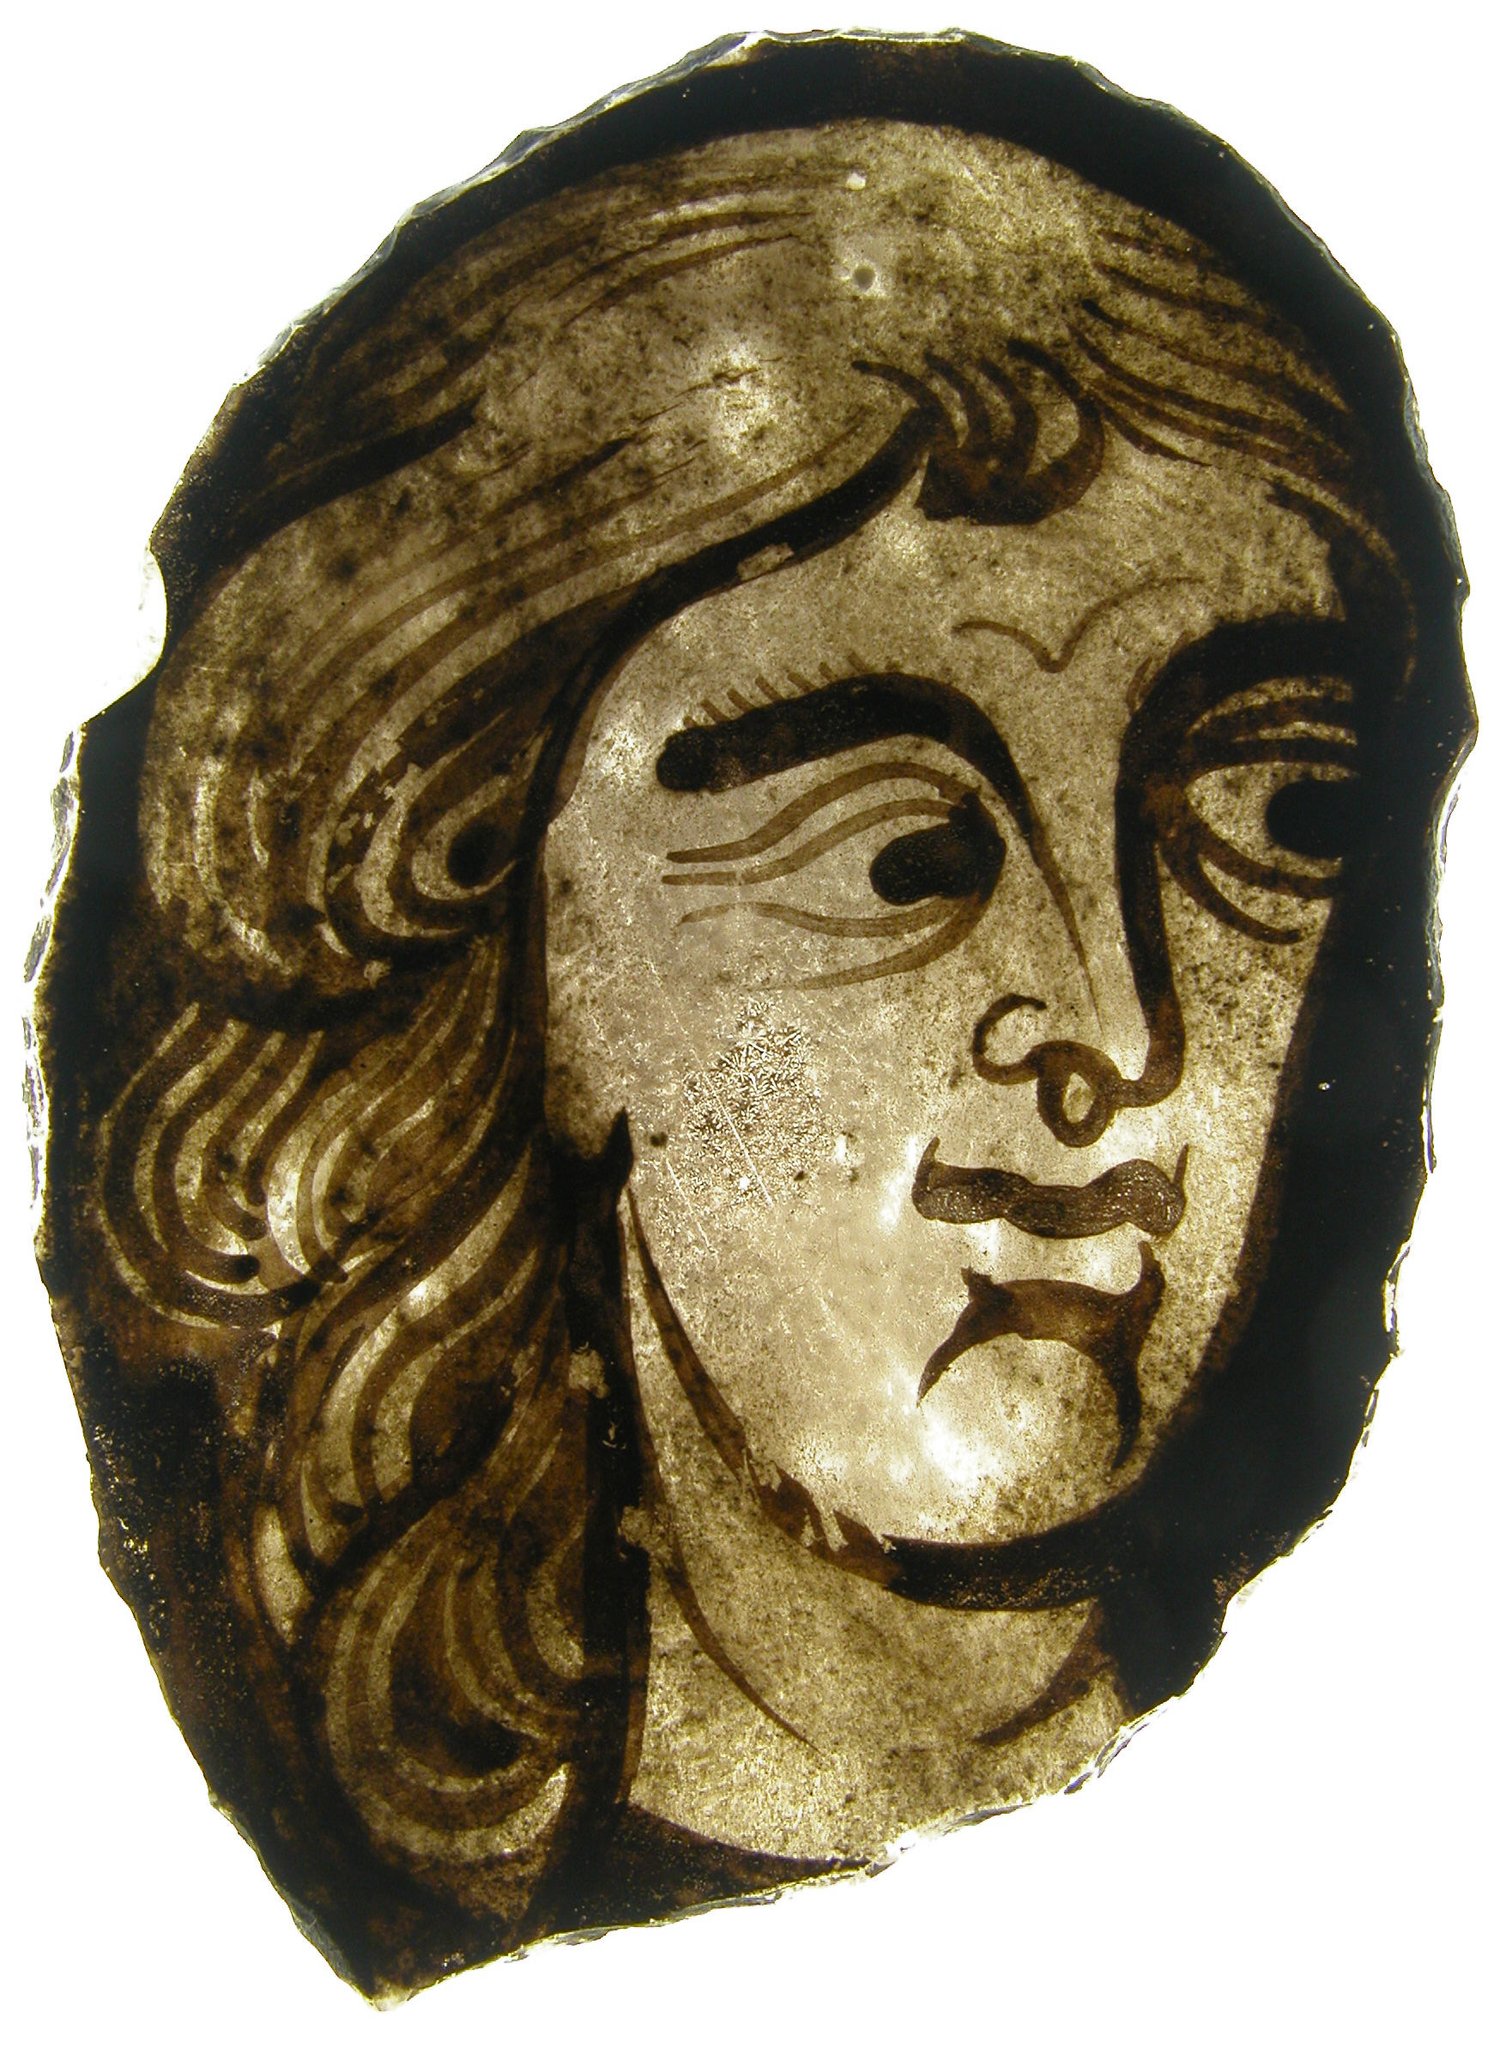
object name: fragment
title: Glass Fragment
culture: french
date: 1201-1400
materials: glass, paint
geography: france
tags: human figures